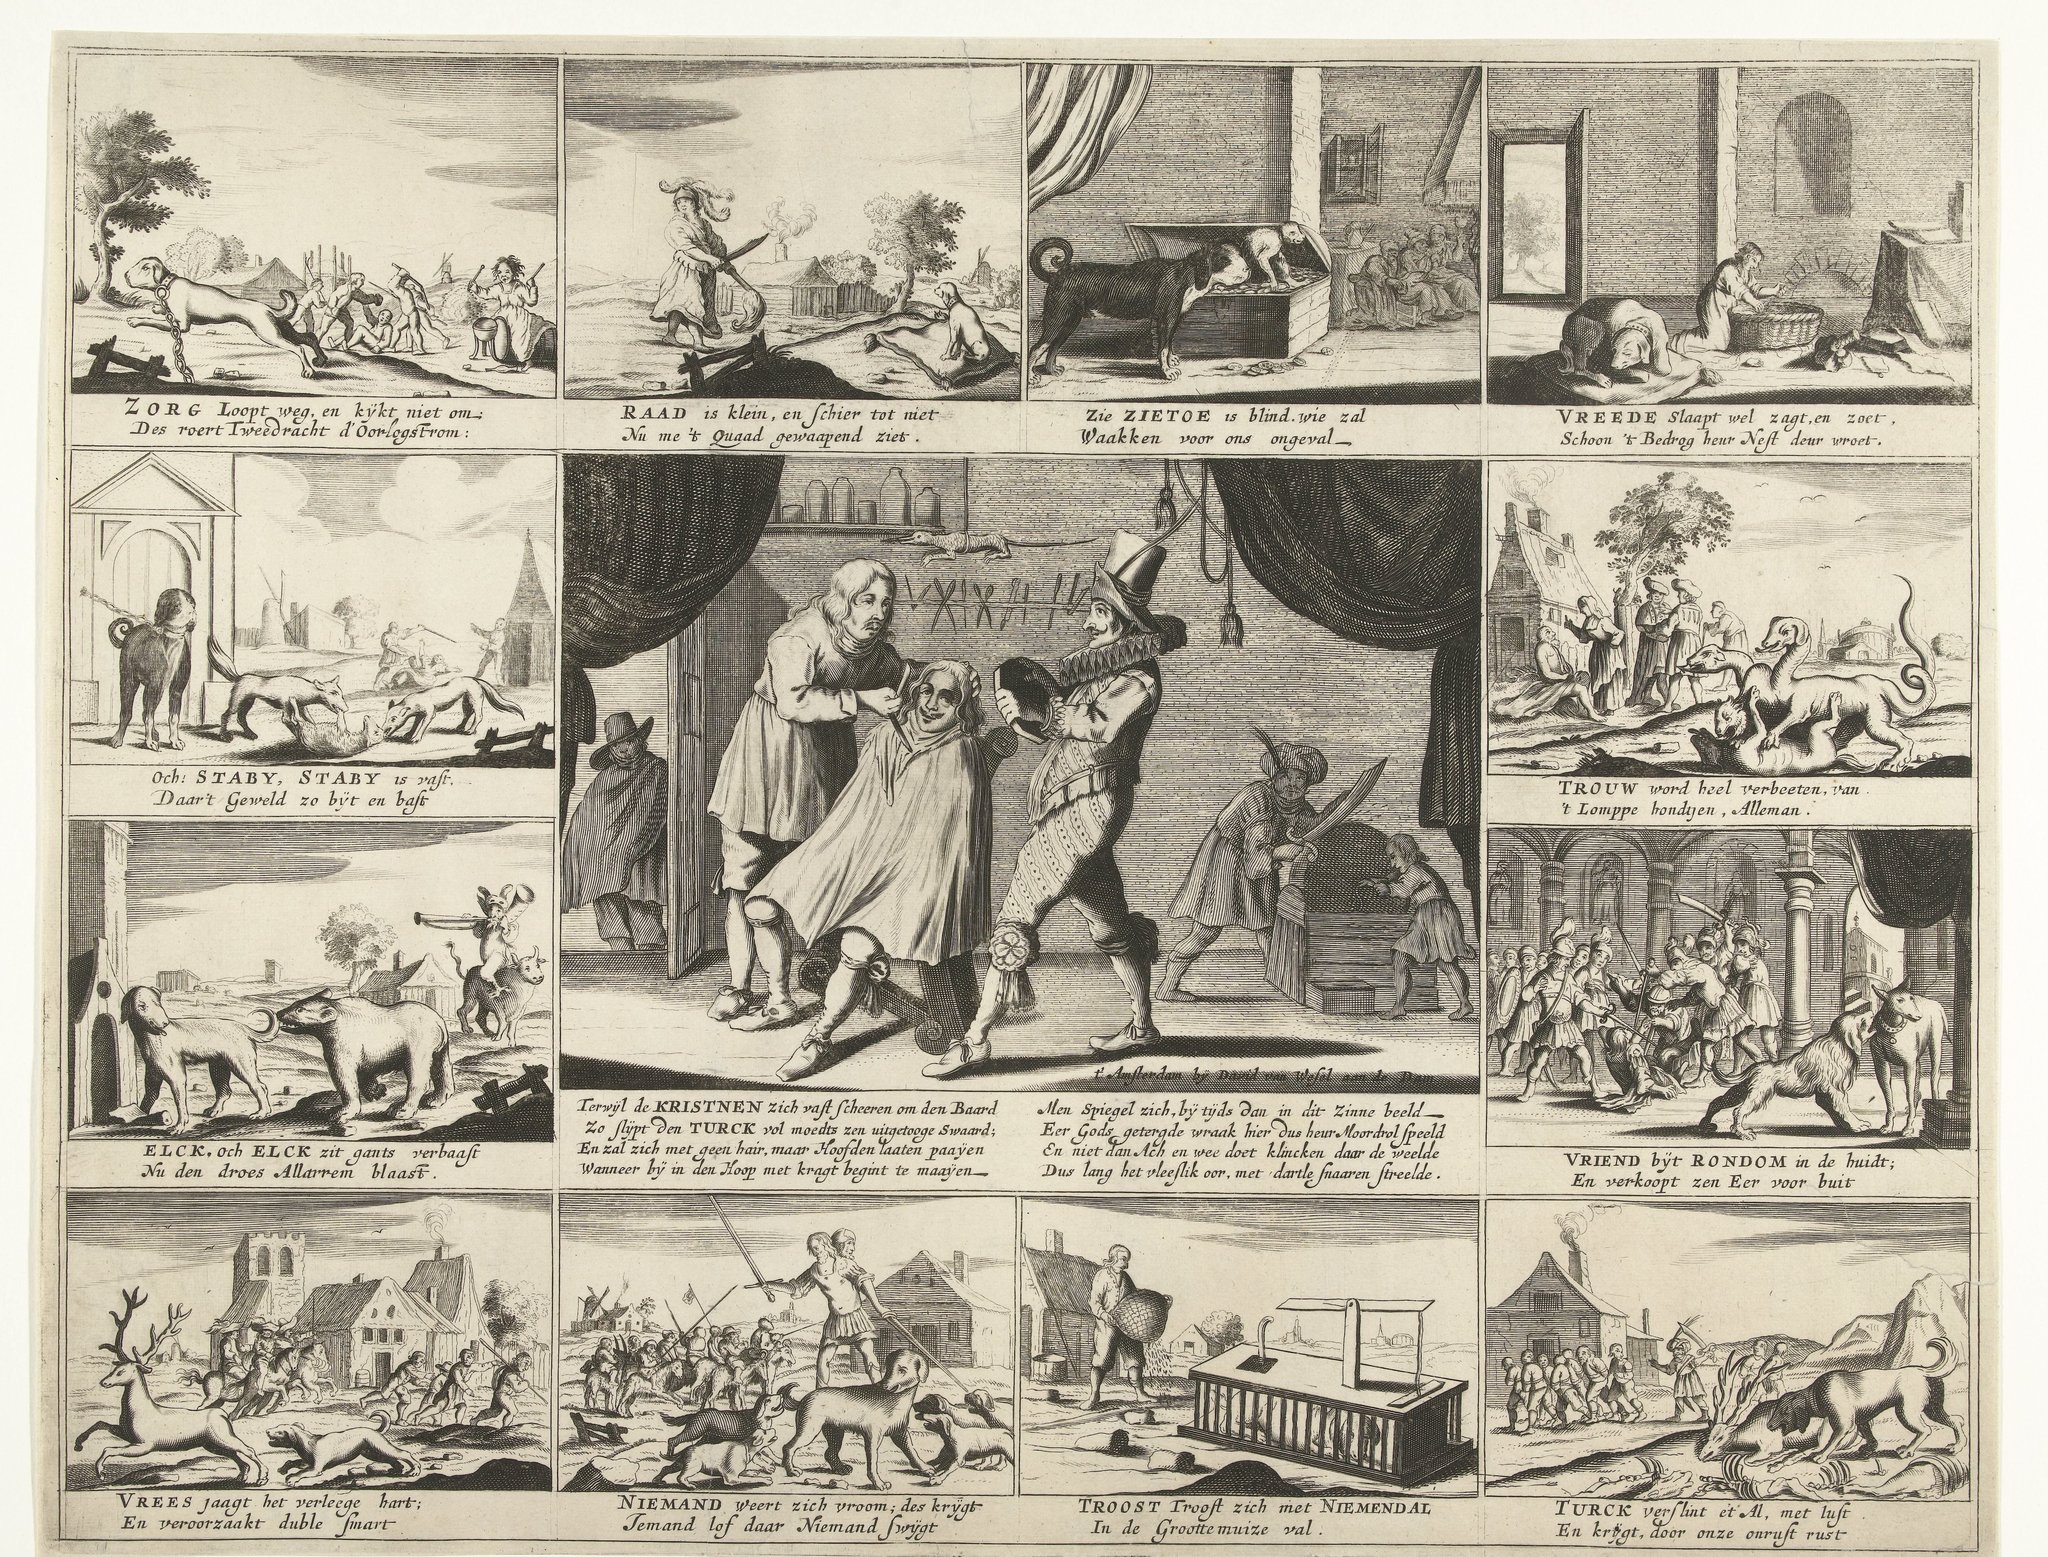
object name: print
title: Terwijl de Kristnen zich vast scheeren om den Baard / Zo slijpt den Turck vol moedts zen uitgetooge Swaard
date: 1664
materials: paper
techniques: engraving, etching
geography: northern netherlands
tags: barber; surgeon, proverbs, sayings, etc., barber, barbershop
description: Allegorie op de voordelen voor de Turken behaald door de verdeeldheid onder de Christelijke naties, ca. 1664. Centrale voorstelling waarin de Hollander in een kapperszaak wordt geknipt en geschoren door de kapper en zijn assistent de Spanjaard met een spiegel, terwijl de Turk zijn kromzwaard slijpt op de achtergrond. Omringd door twaalf kleine allegorische scènes waarin een relevant gezegde wordt verbeeld.